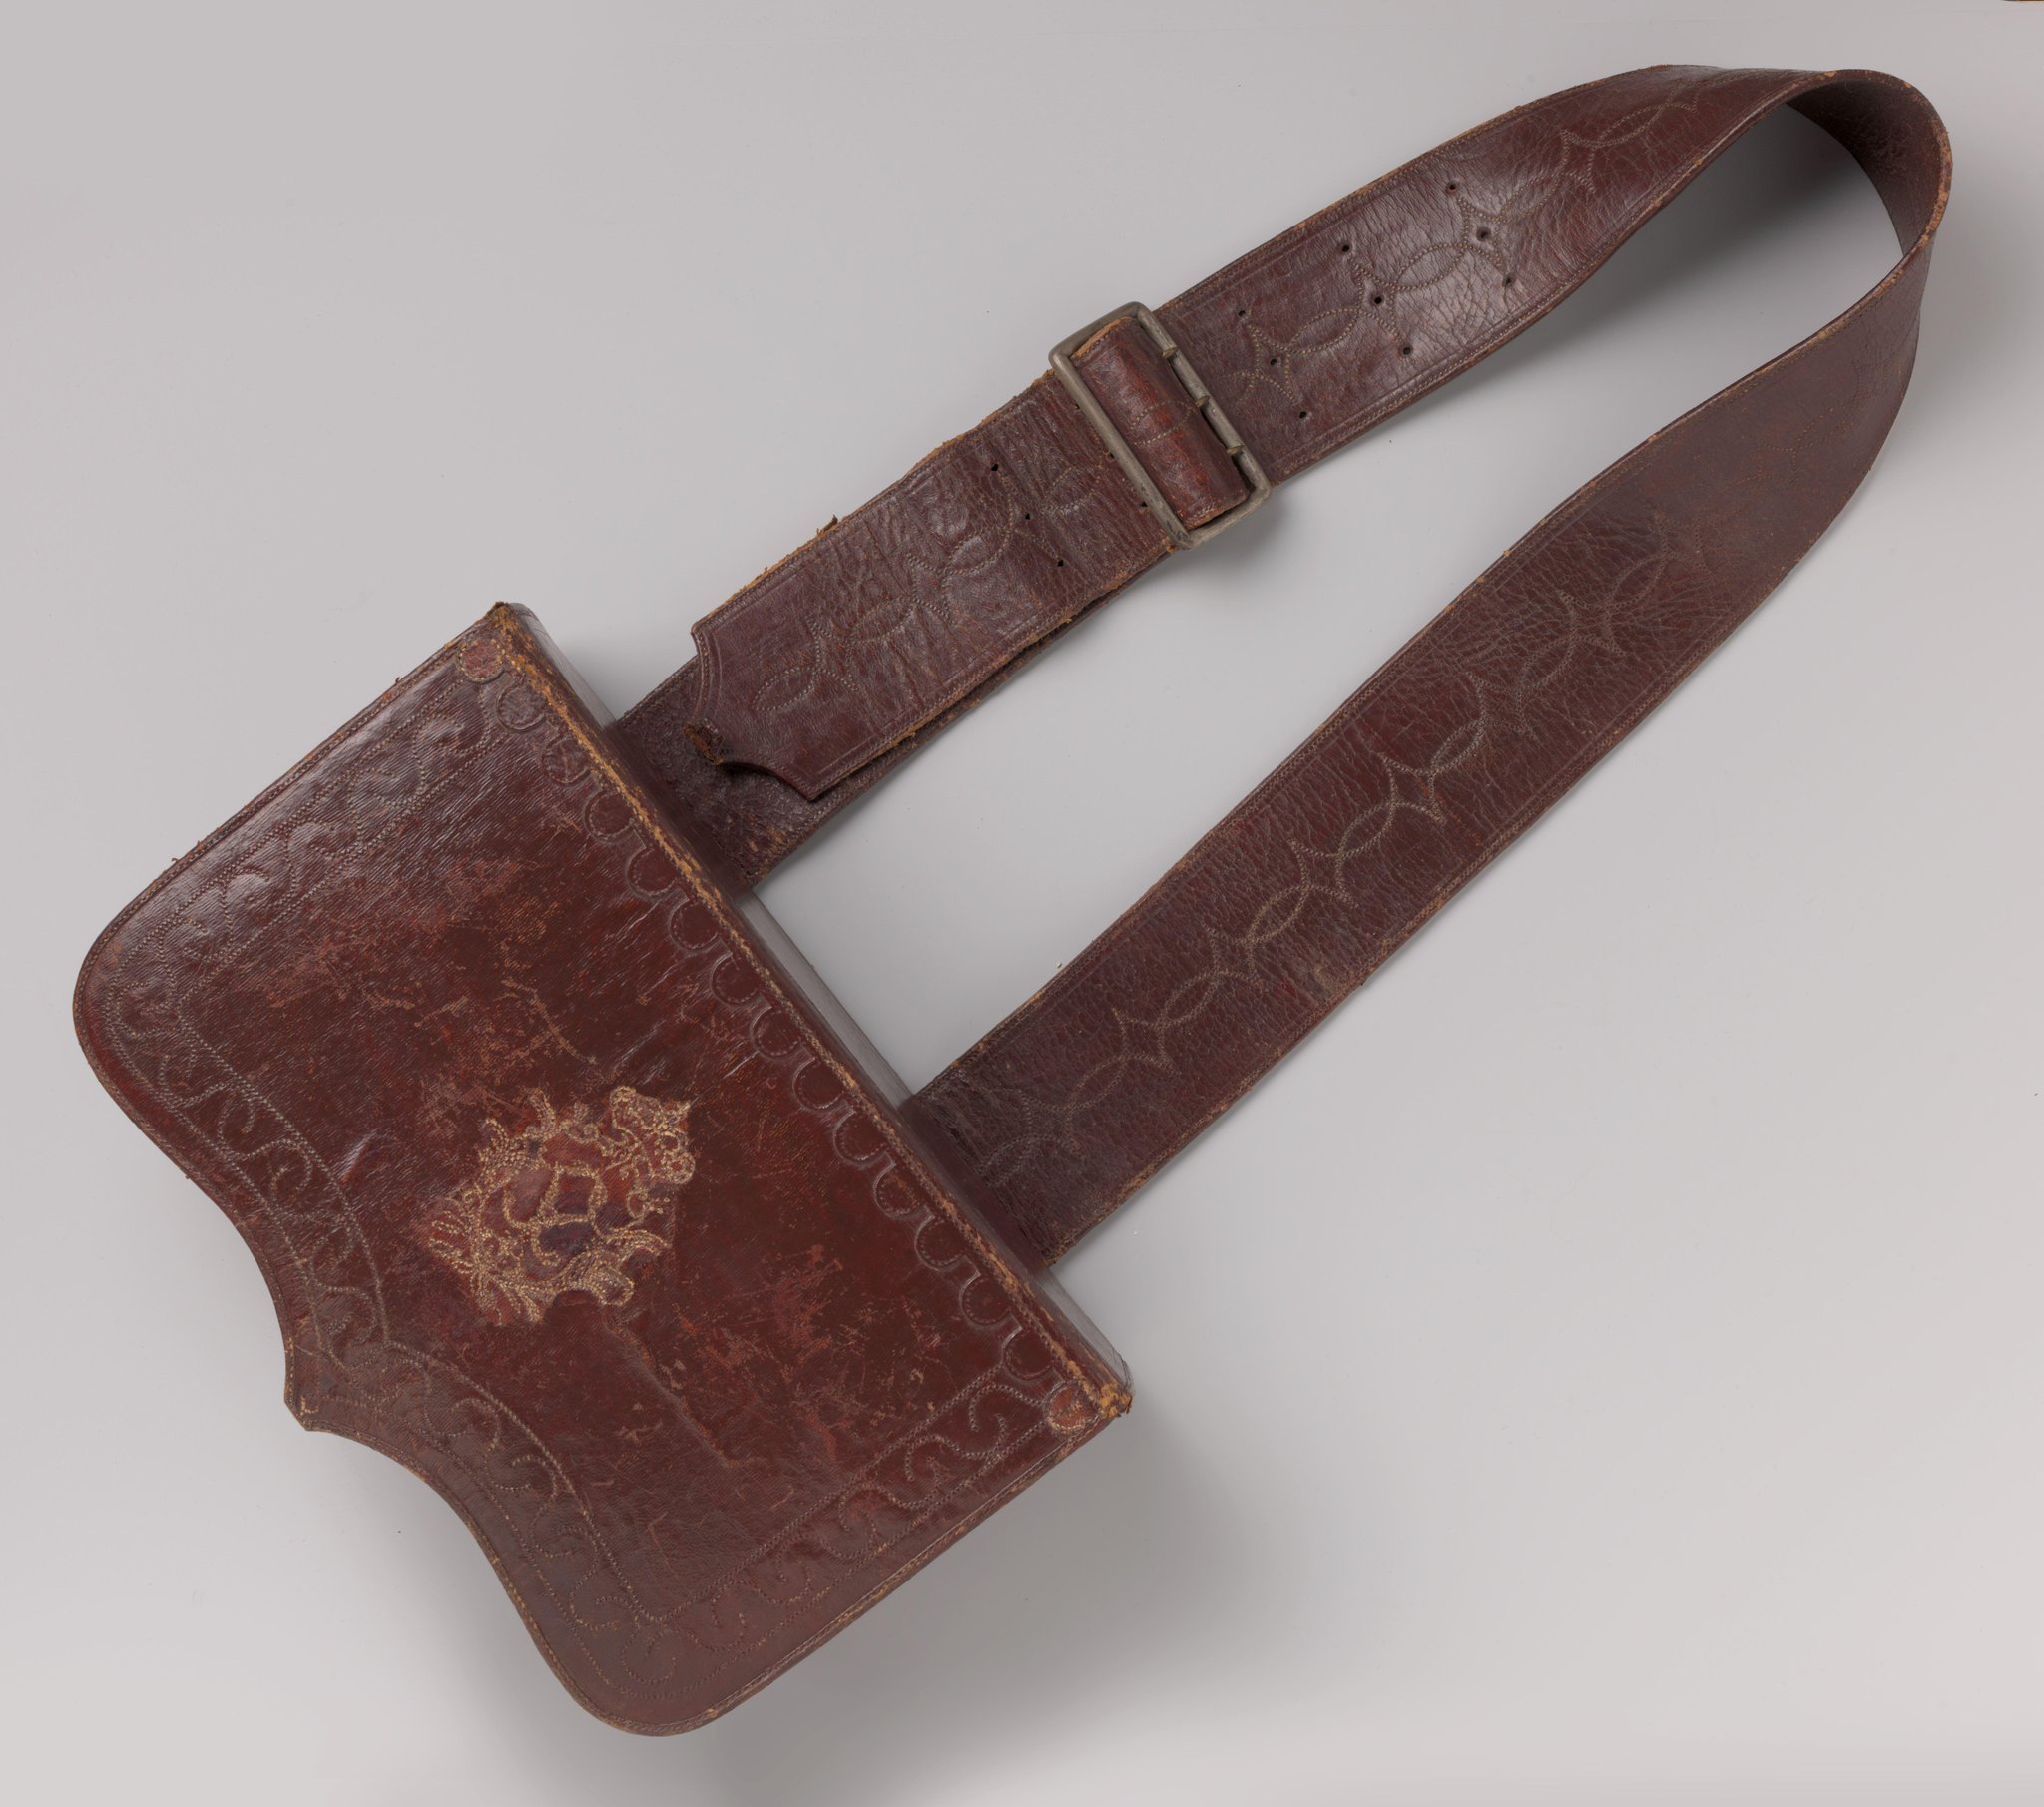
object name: bag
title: Rechthoekige tas met deksel er overheen geslagen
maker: Anonymous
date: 1700-1800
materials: copper, iron, leather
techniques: cutting, sewing, tanning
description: Rechthoekige tas met deksel er overheen geslagen. De tas is van binnen in de lengte doormidden gedeeld. De voorste helft heeft zeven even grote vakken. De achterste helft heeft twee vakken. De draagriem is met stikwerk versierd, en heeft aan het uiteinde een punt. De deksel zit met een flap over de tas. De deksel heeft ronde hoeken en een punt in het midden. De deksel heeft middenin, in koperbeslag, een gekroond wapen als versiering. Bovenlangs de flap zit een versiering van leer.